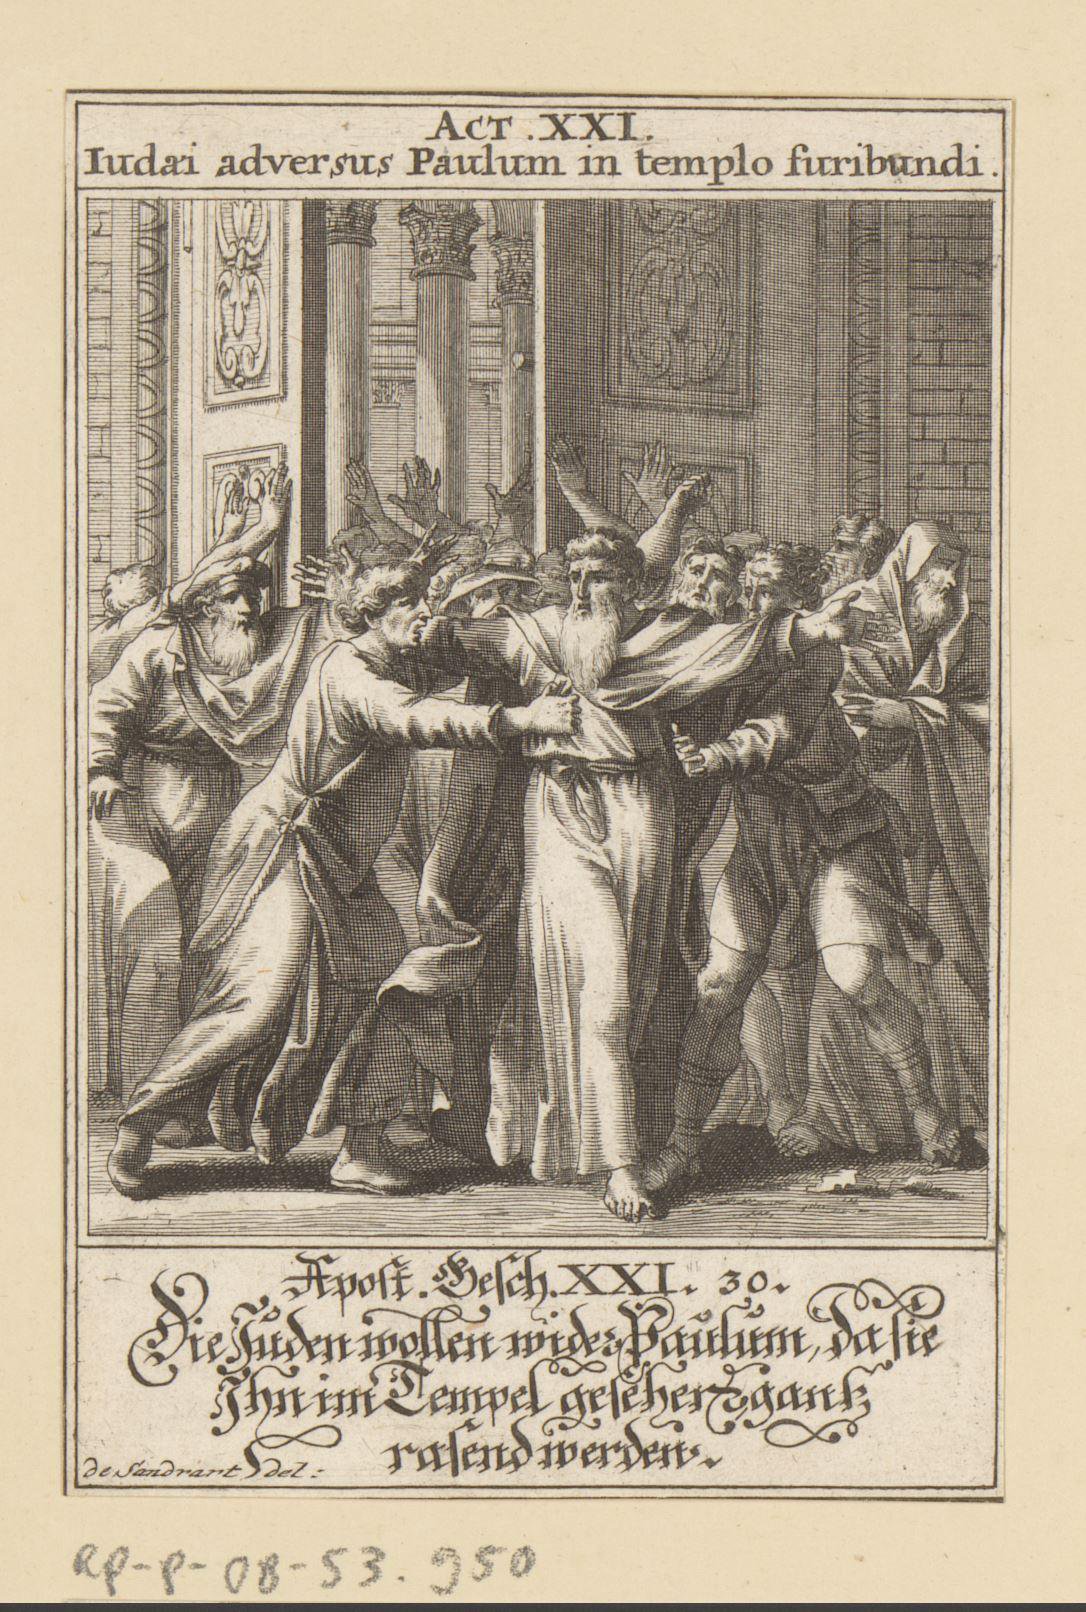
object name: print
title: Joden grijpen apostel Paulus in de tempel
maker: Anonymous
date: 1697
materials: paper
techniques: etching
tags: paul is dragged out of the temple by the jews; he is rescued by soldiers, who arrest him and carry him away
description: Prent ook gebruikt in: Biblia ectypa : Bildnussen auss Heiliger Schrifft. Regensburg: Chr. Wiegel, 1697.